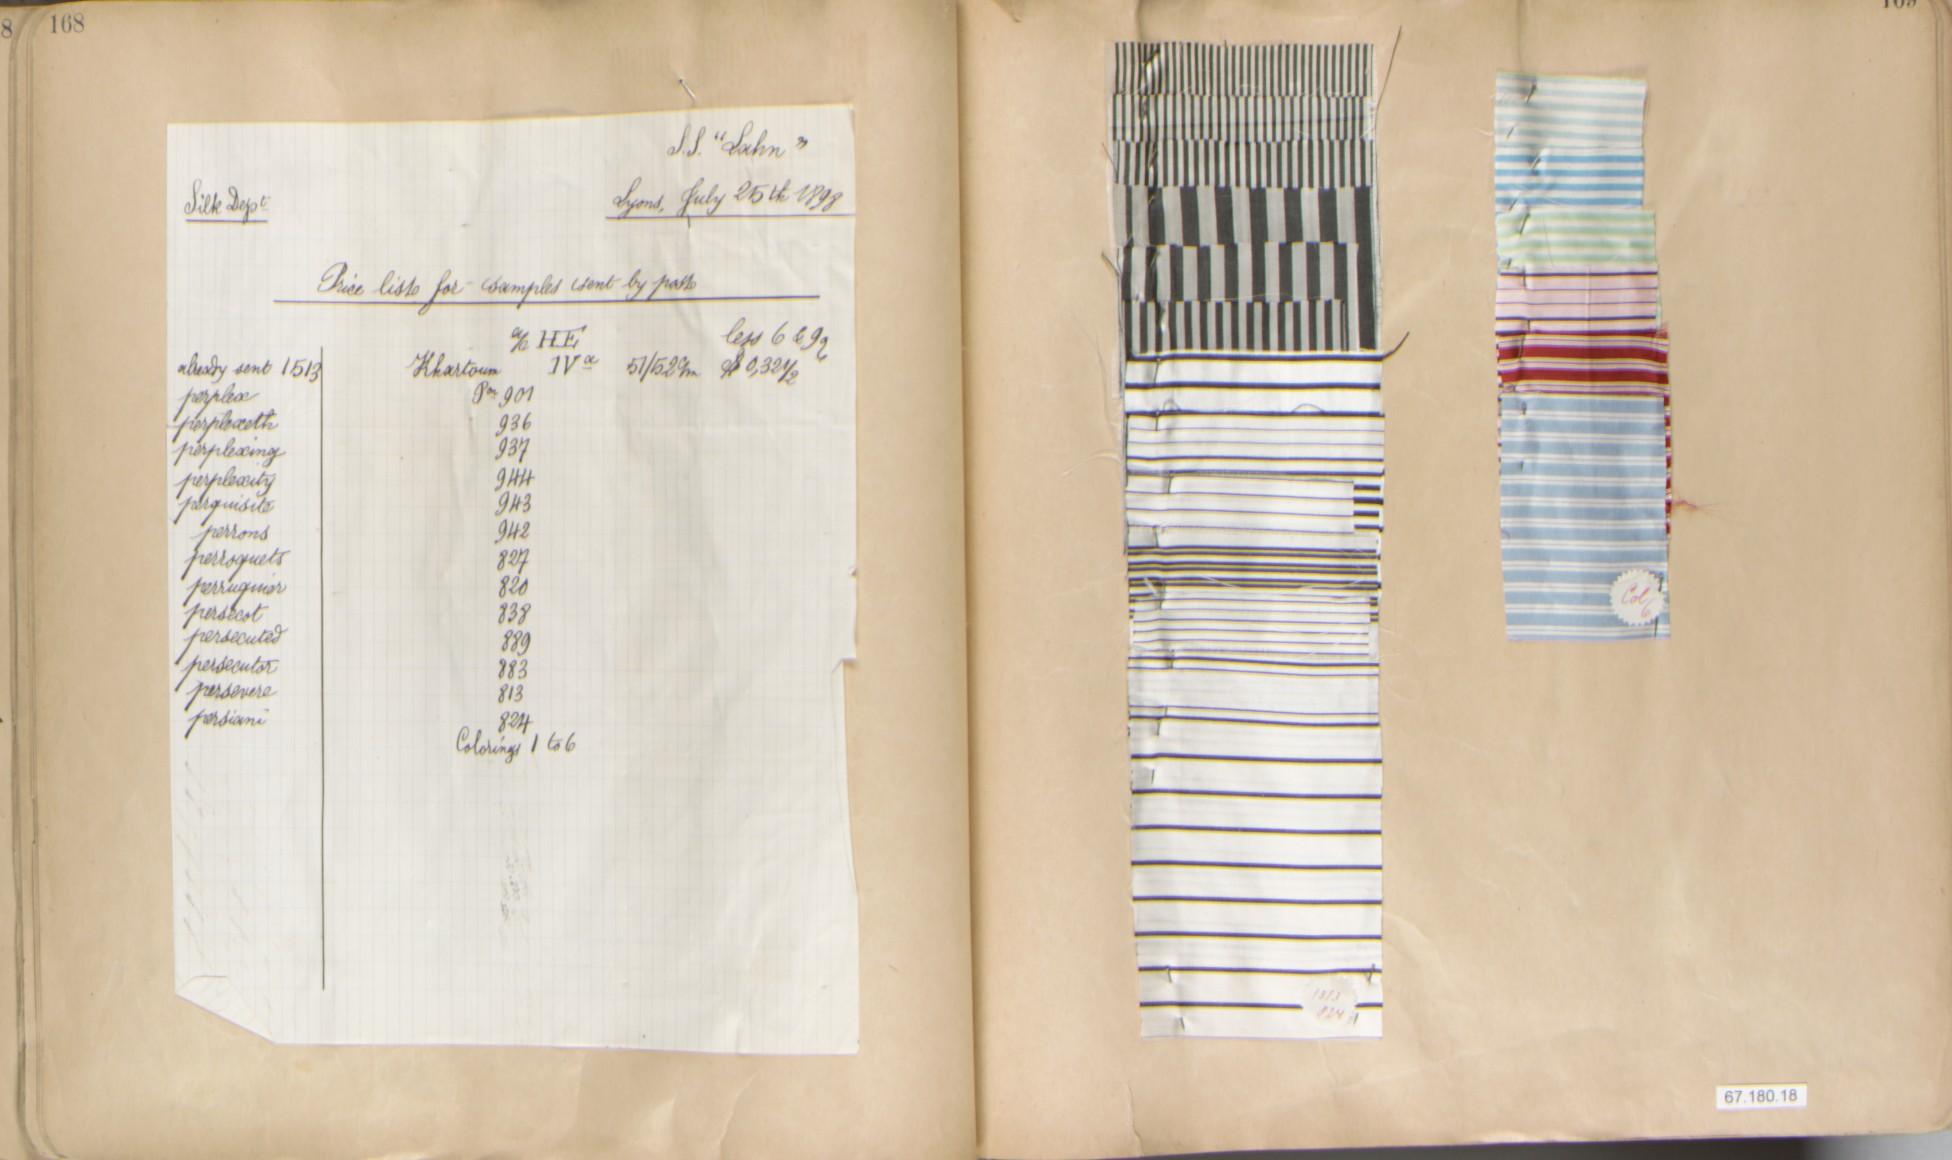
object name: sample book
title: Textile Sample Book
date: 1897-1899